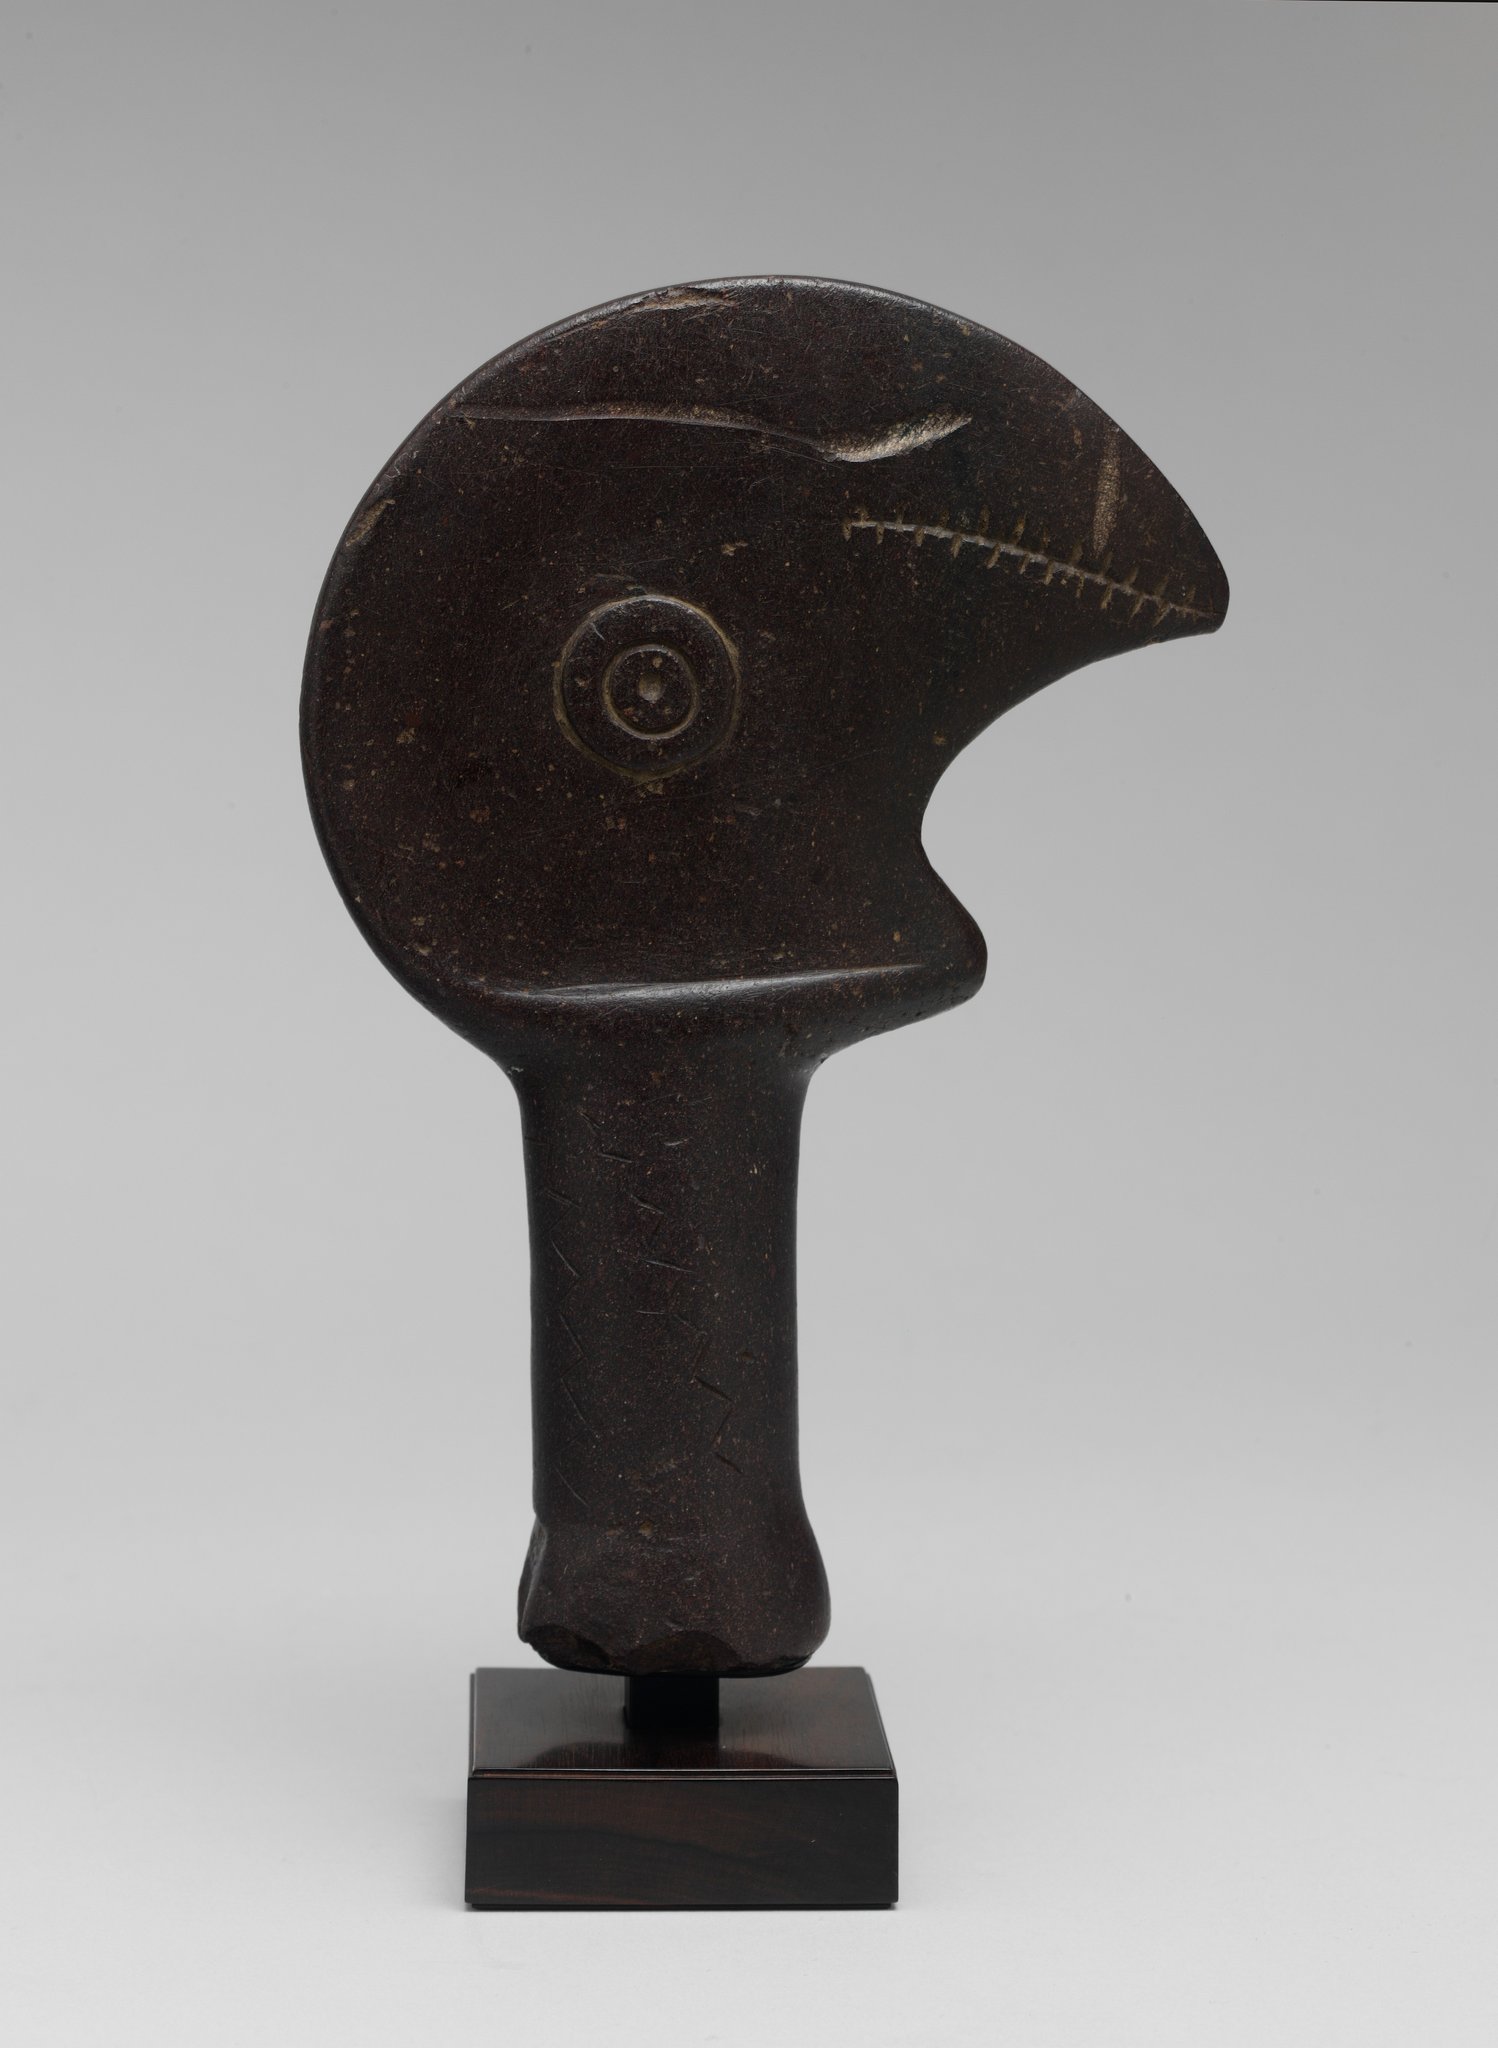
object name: scepter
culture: chilean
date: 1201-1700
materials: stone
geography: chile